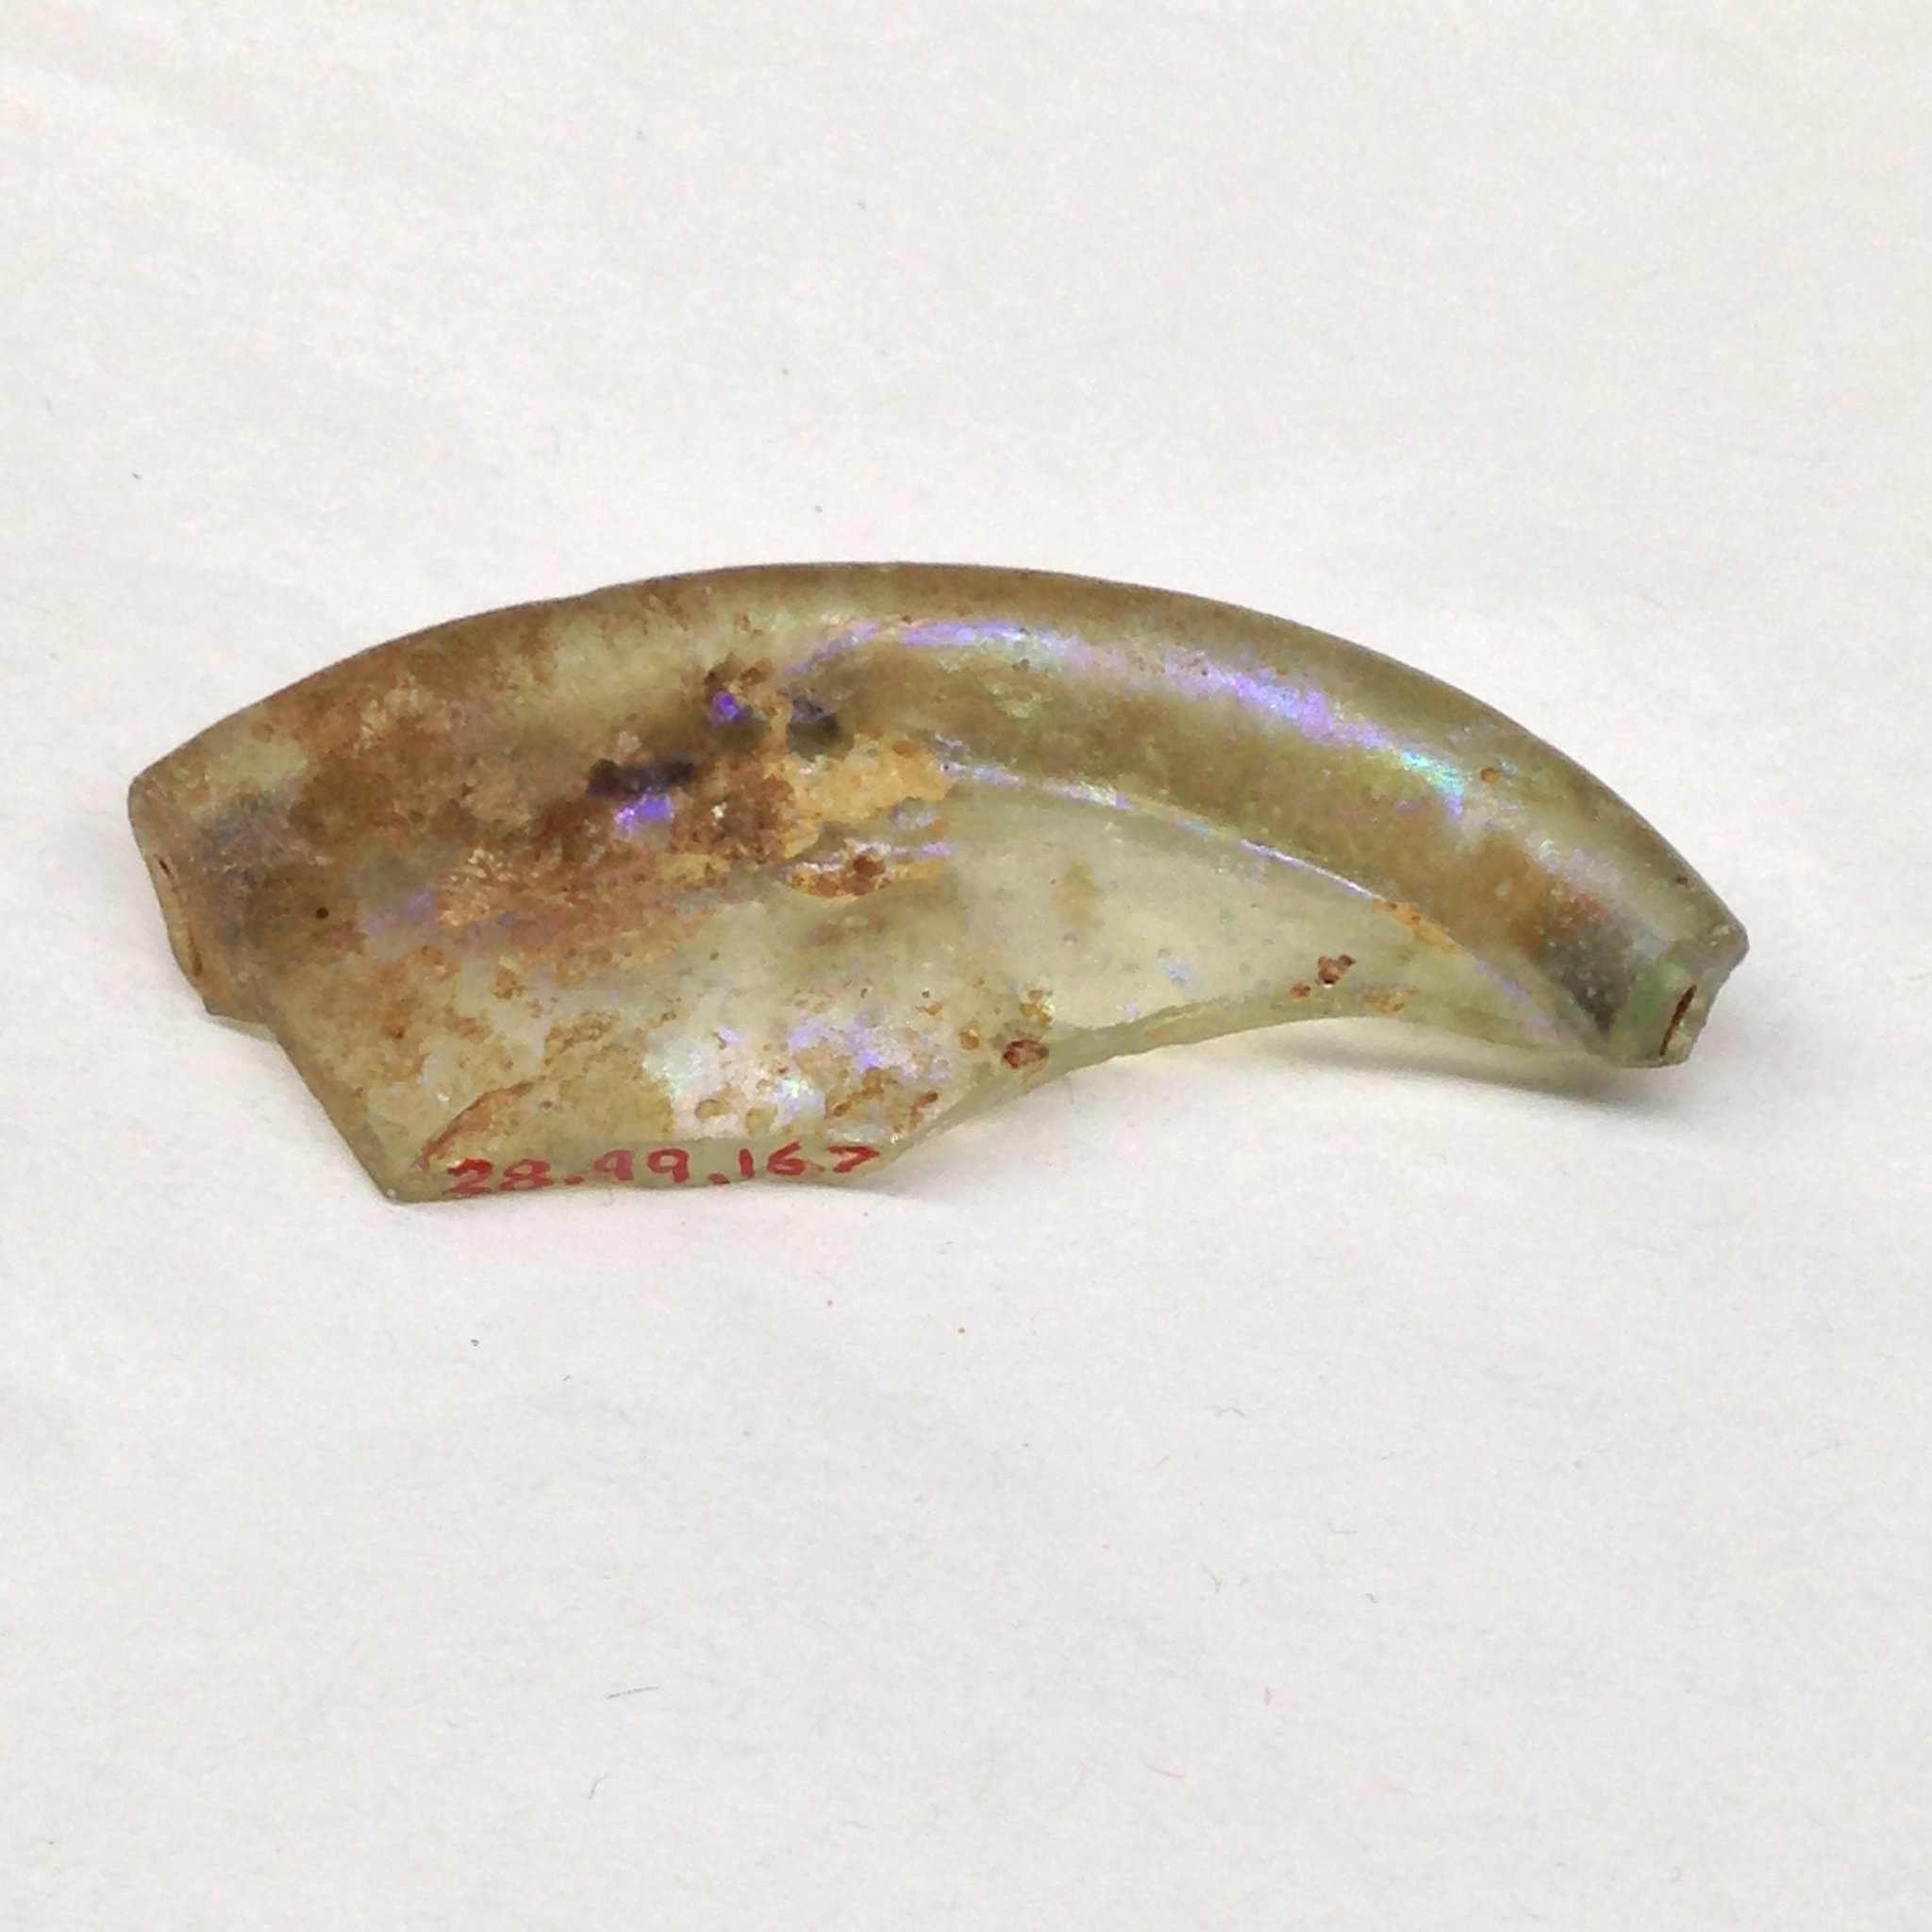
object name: fragment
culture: european or middle eastern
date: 1150-1250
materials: ceramic, glass